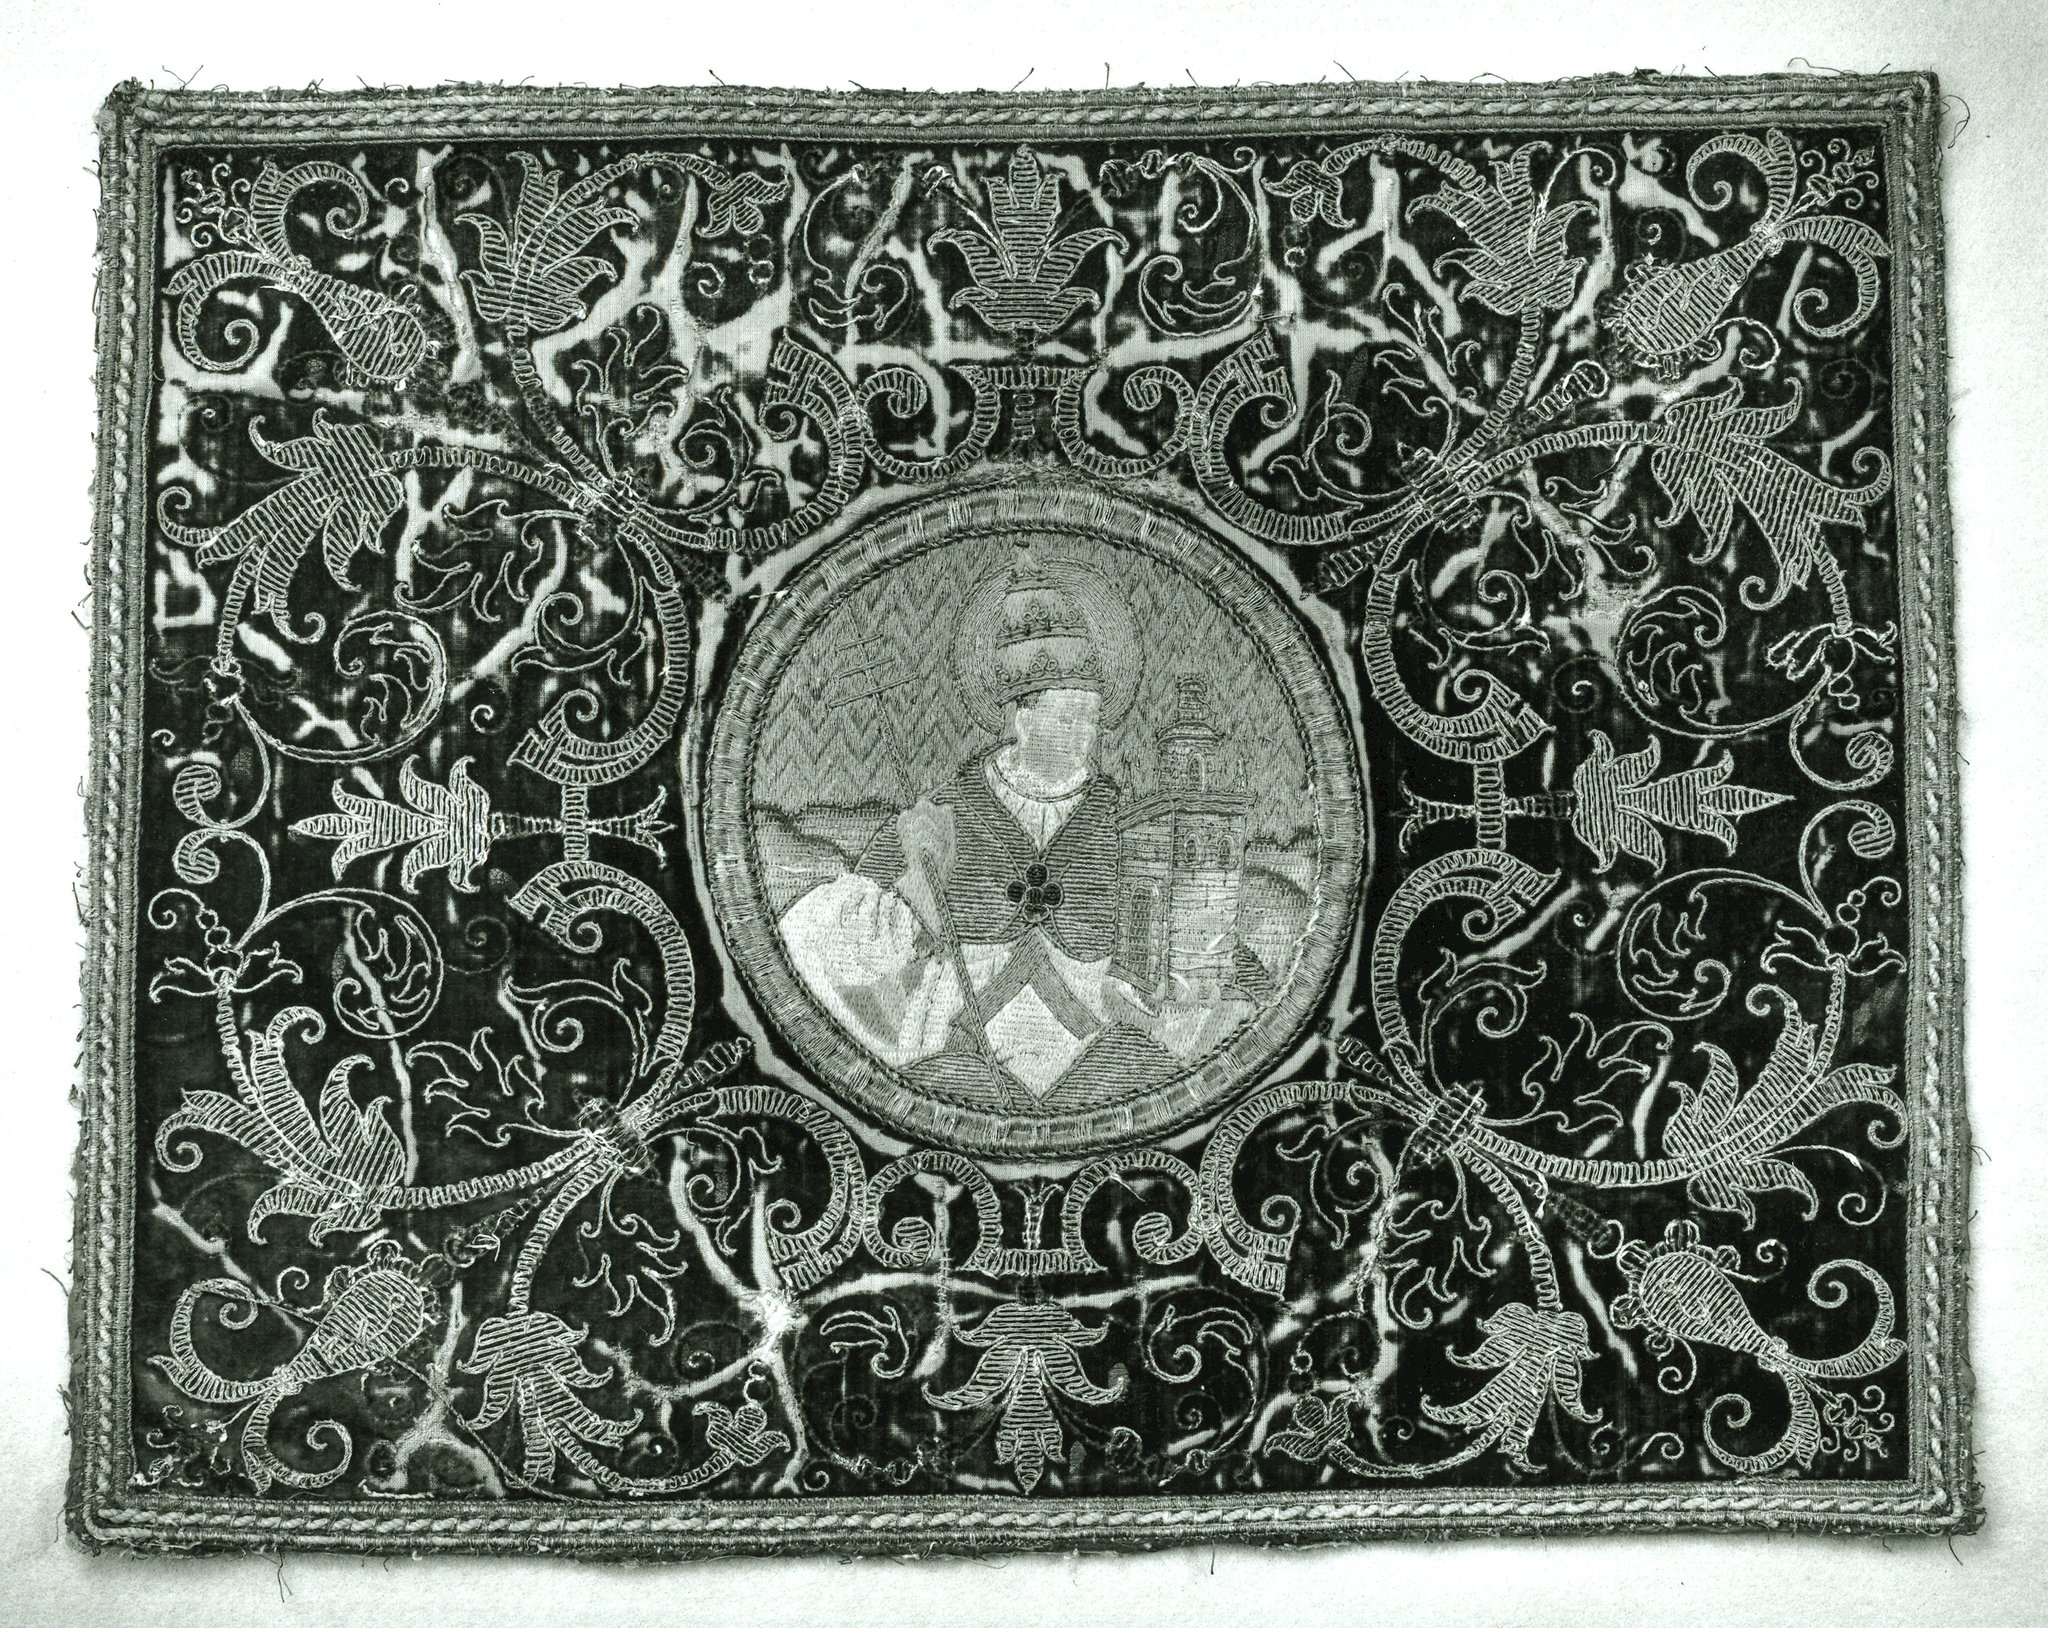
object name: roundel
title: Roundel appliquéd to rectangular panel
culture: italian or spanish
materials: gilt, linen, metal, metal thread, silk, velvet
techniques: embroidery, cutting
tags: men